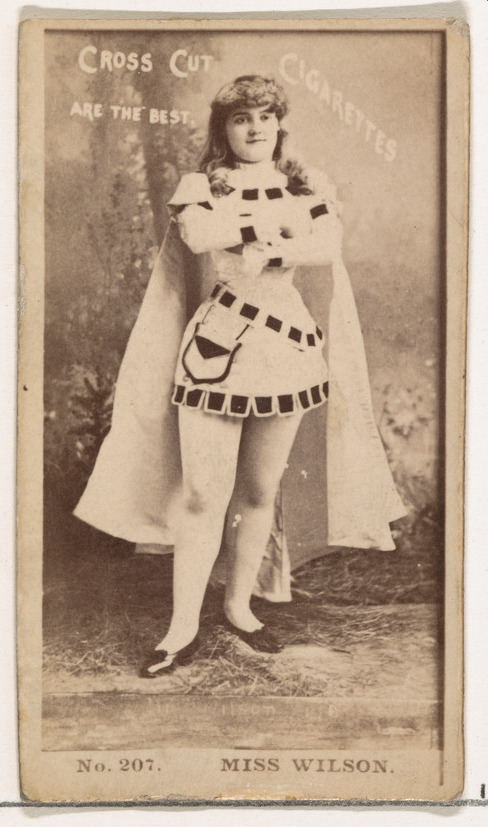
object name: print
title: Card Number 207, Miss Wilson, from the Actors and Actresses series (N145-2) issued by Duke Sons & Co. to promote Cross Cut Cigarettes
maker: w. duke, sons & co.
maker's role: publisher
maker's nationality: american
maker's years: 1870-1920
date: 1880-1889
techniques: albumen silver print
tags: portraits,women,actresses